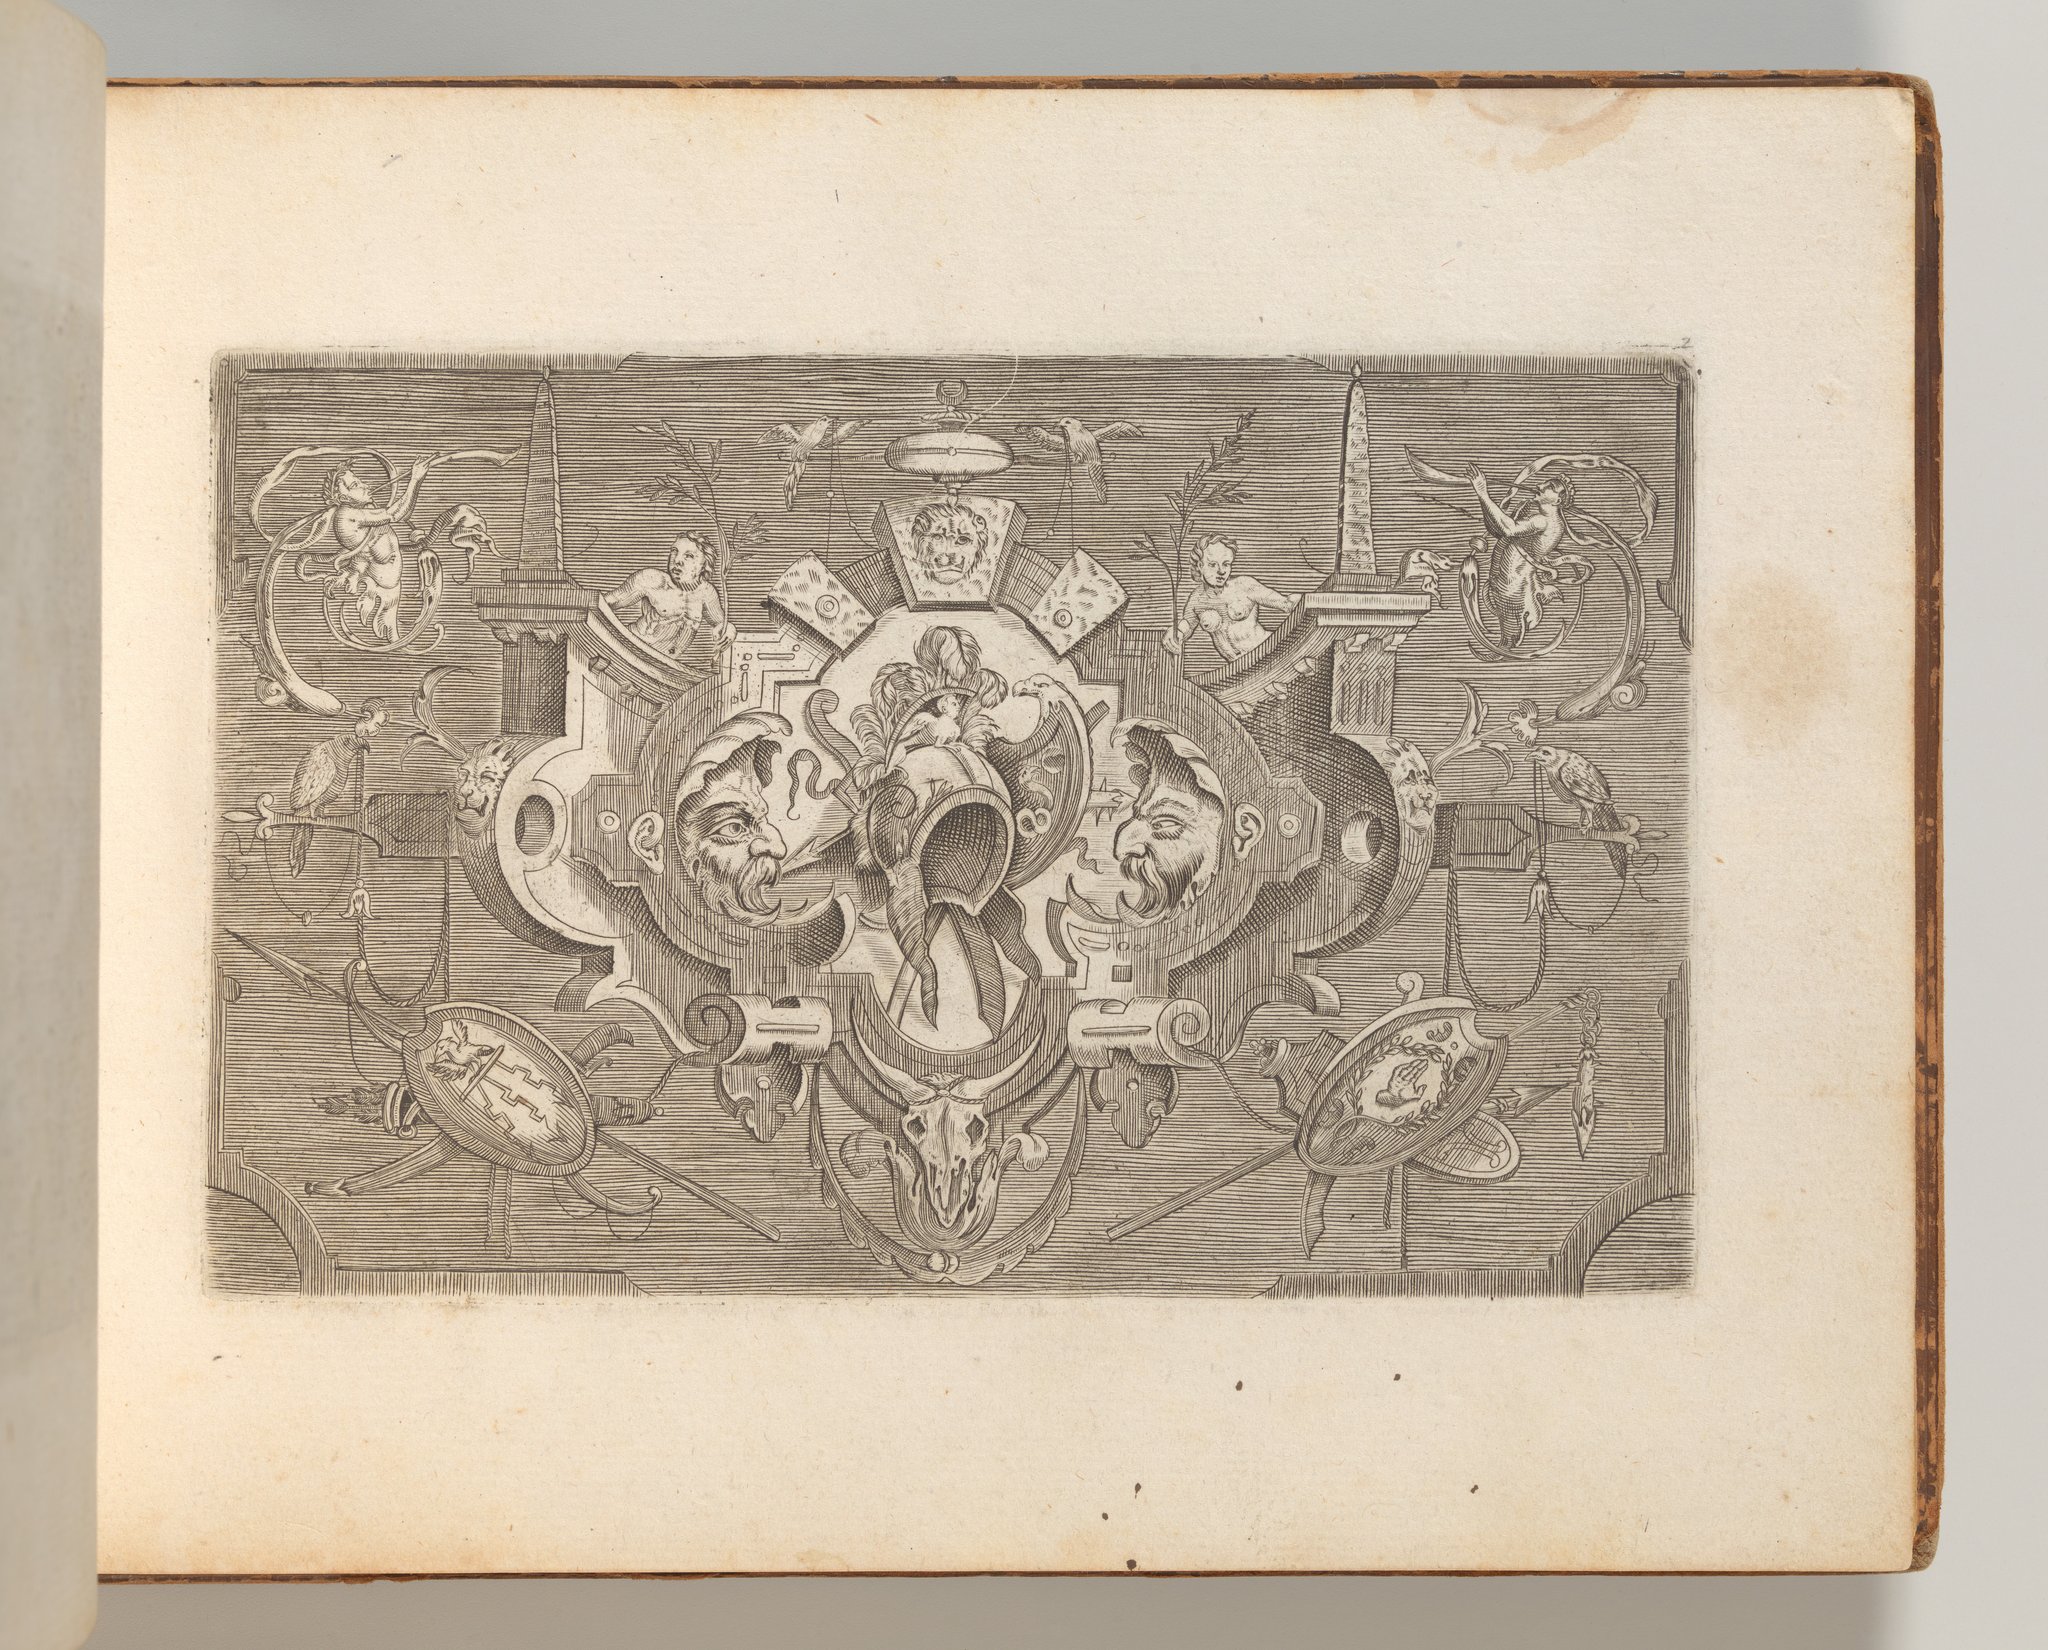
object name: album print ornament architecture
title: Targhe ed altri ornati di varie e capricciose invenzioni (Cartouches and other ornaments of various and capricious invention, page 2)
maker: jacob floris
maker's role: artist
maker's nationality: central european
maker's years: 1524-1581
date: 1773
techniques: engraving, etching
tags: birds,obelisks,shields,spears,female nudes